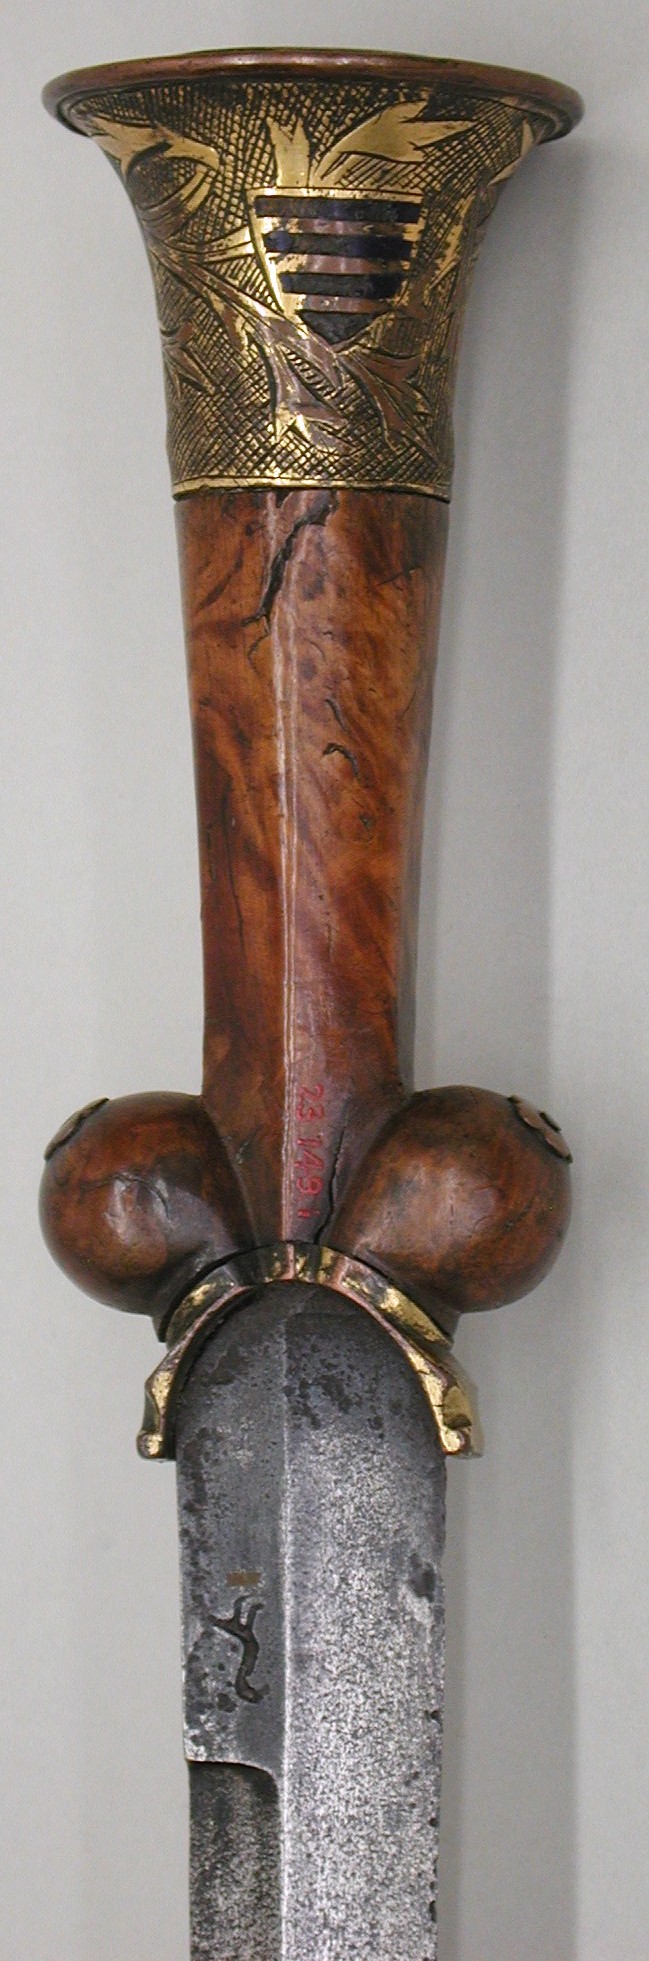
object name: kidney dagger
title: Kidney Dagger in Gothic Style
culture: french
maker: henri husson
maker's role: maker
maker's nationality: french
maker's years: 1852-1914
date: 1880-1890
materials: copper, enamel, steel, wood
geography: france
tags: coat of arms